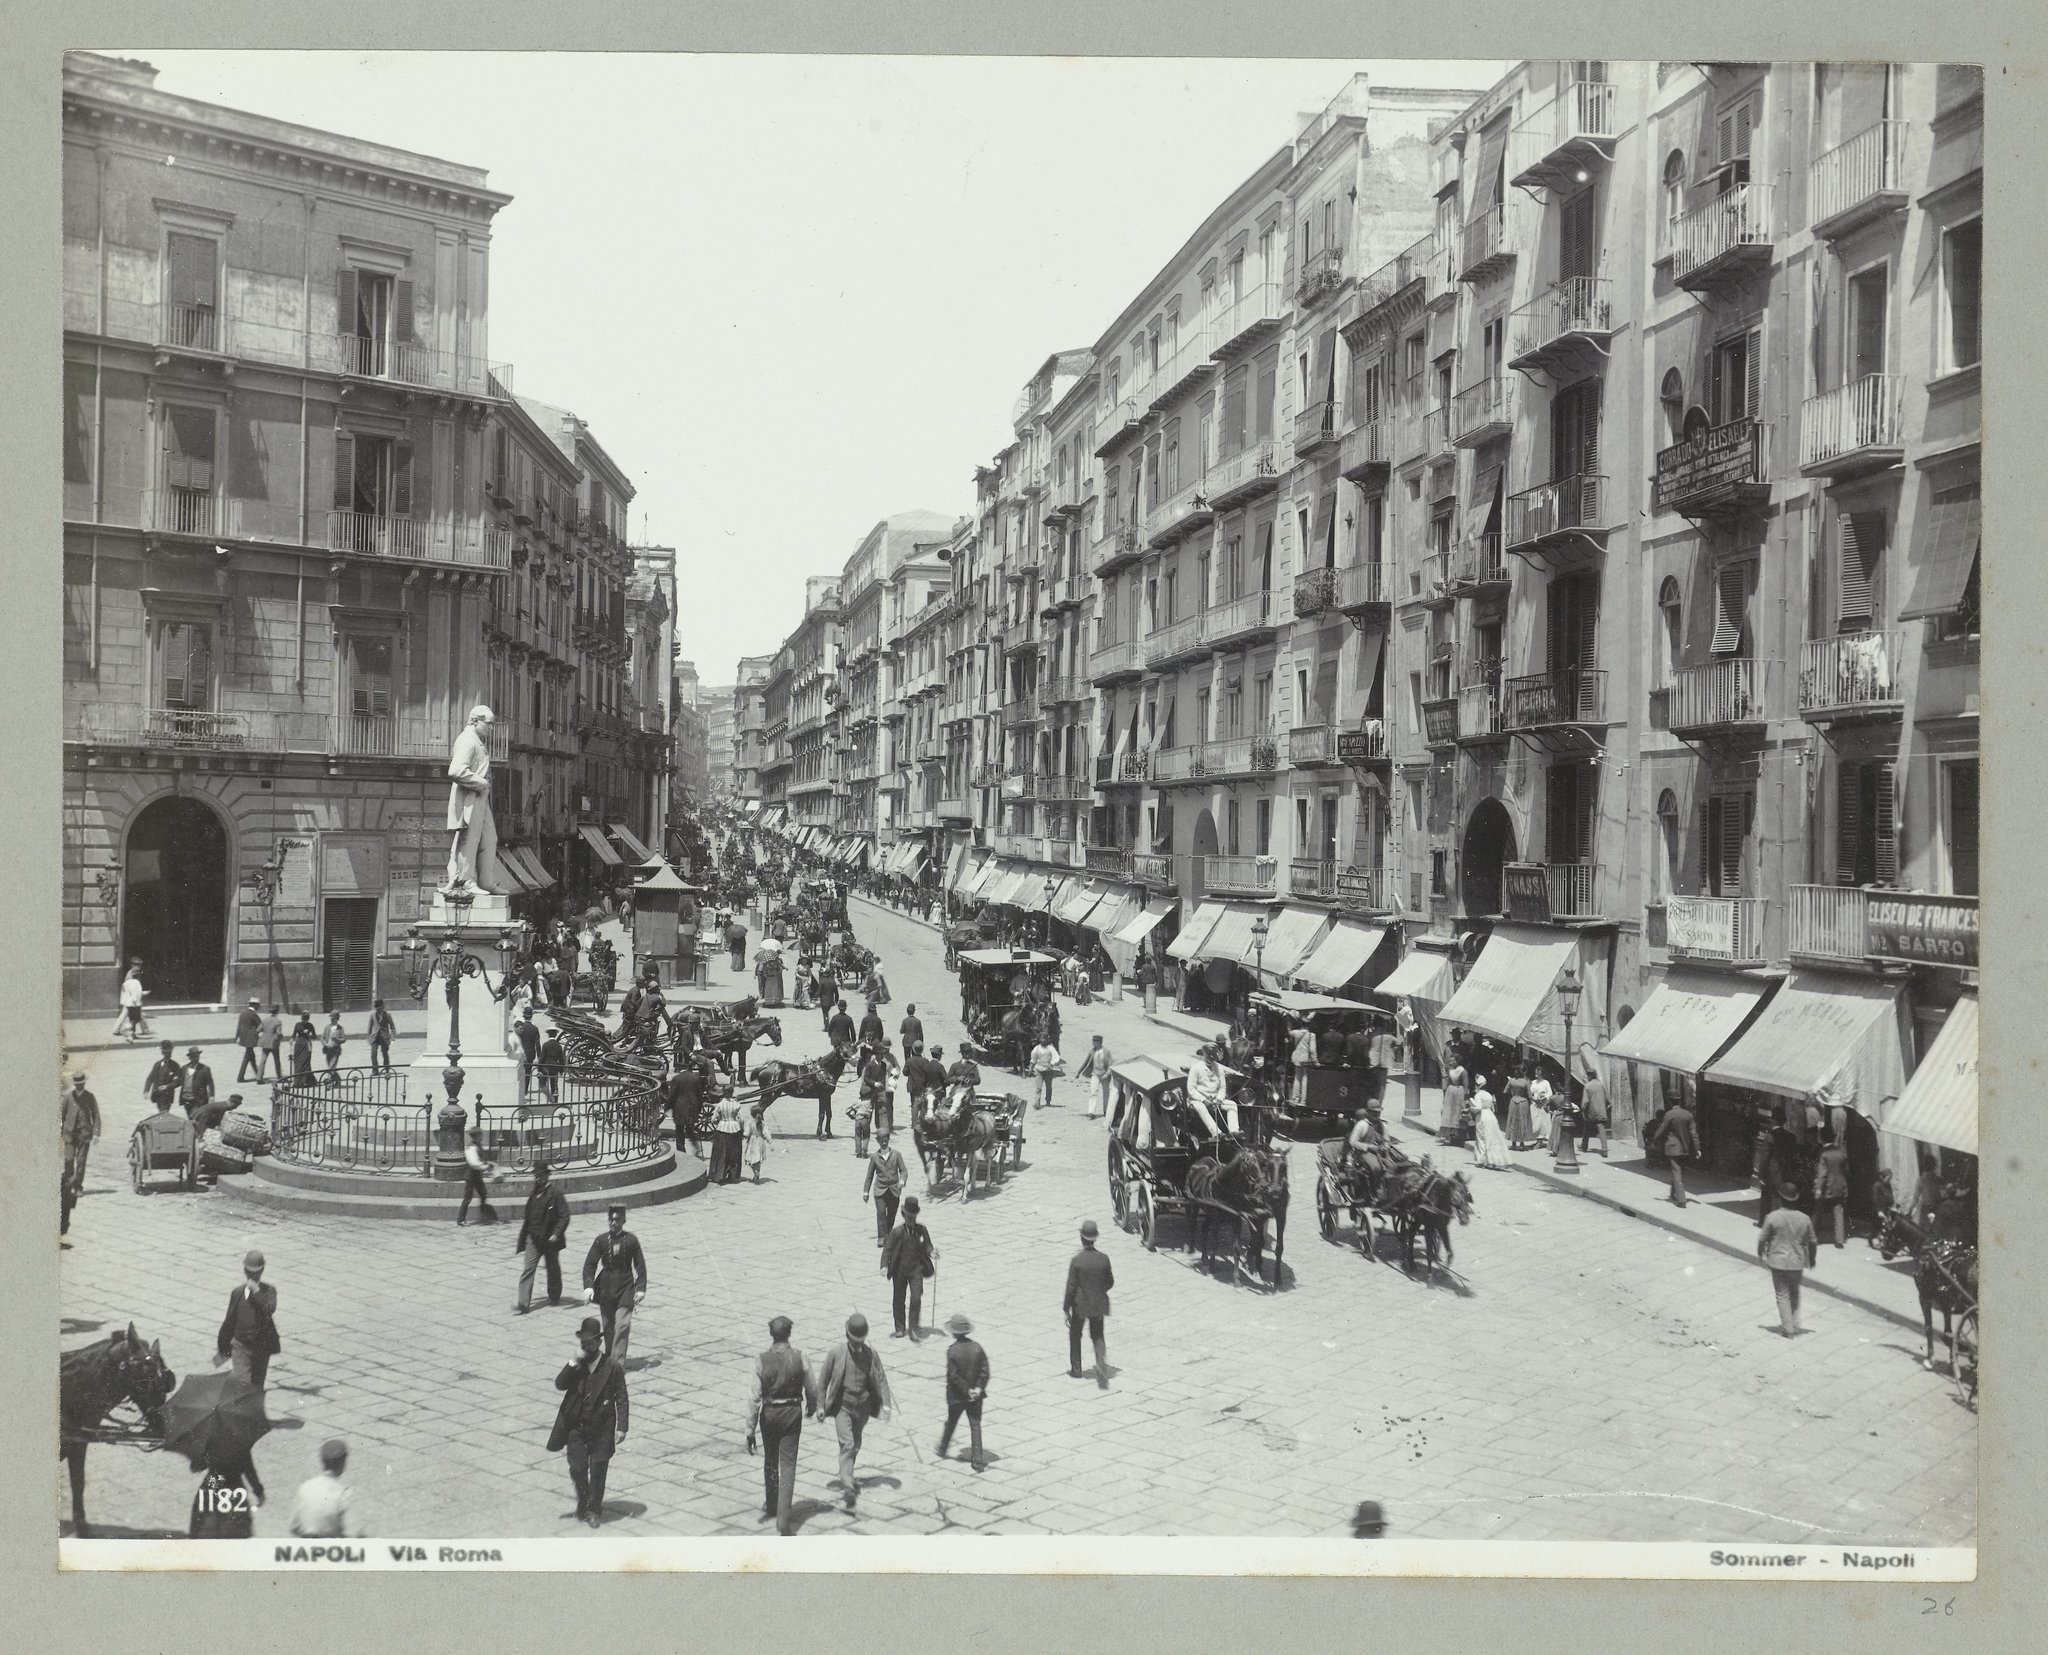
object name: photograph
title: 1182 Napoli via Roma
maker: giorgio sommer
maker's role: fotograaf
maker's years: 1834-1914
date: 1893-1903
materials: cardboard, photographic support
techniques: albumen print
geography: netherlands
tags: naples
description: Een straatgezicht in Napels waarin een aantal door paarden voortgetrokken rijtuigen.